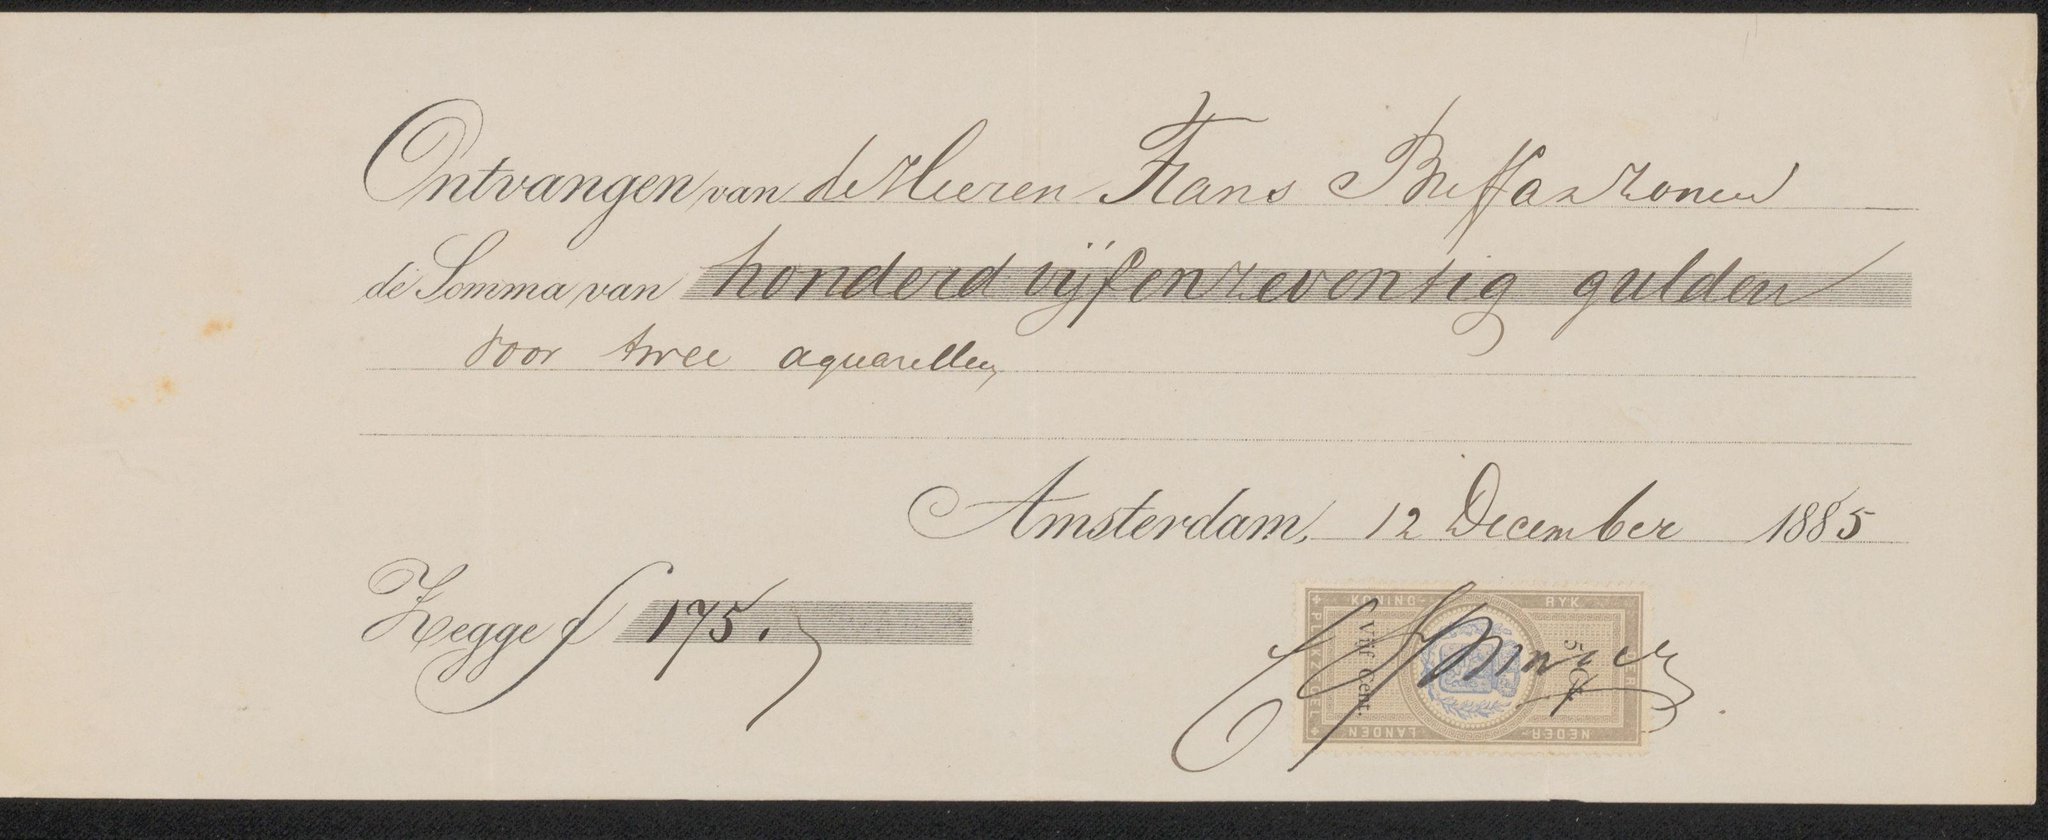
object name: ontvangstbewijs, kwitantie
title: Kwitantie voor Cornelis Springer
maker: cornelis springer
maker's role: draughtsman, painter, print maker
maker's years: 1817-1891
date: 1885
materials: ink, paper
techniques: pen, printing, writing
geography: amsterdam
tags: drawing, money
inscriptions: collector's mark: Lugt 2233